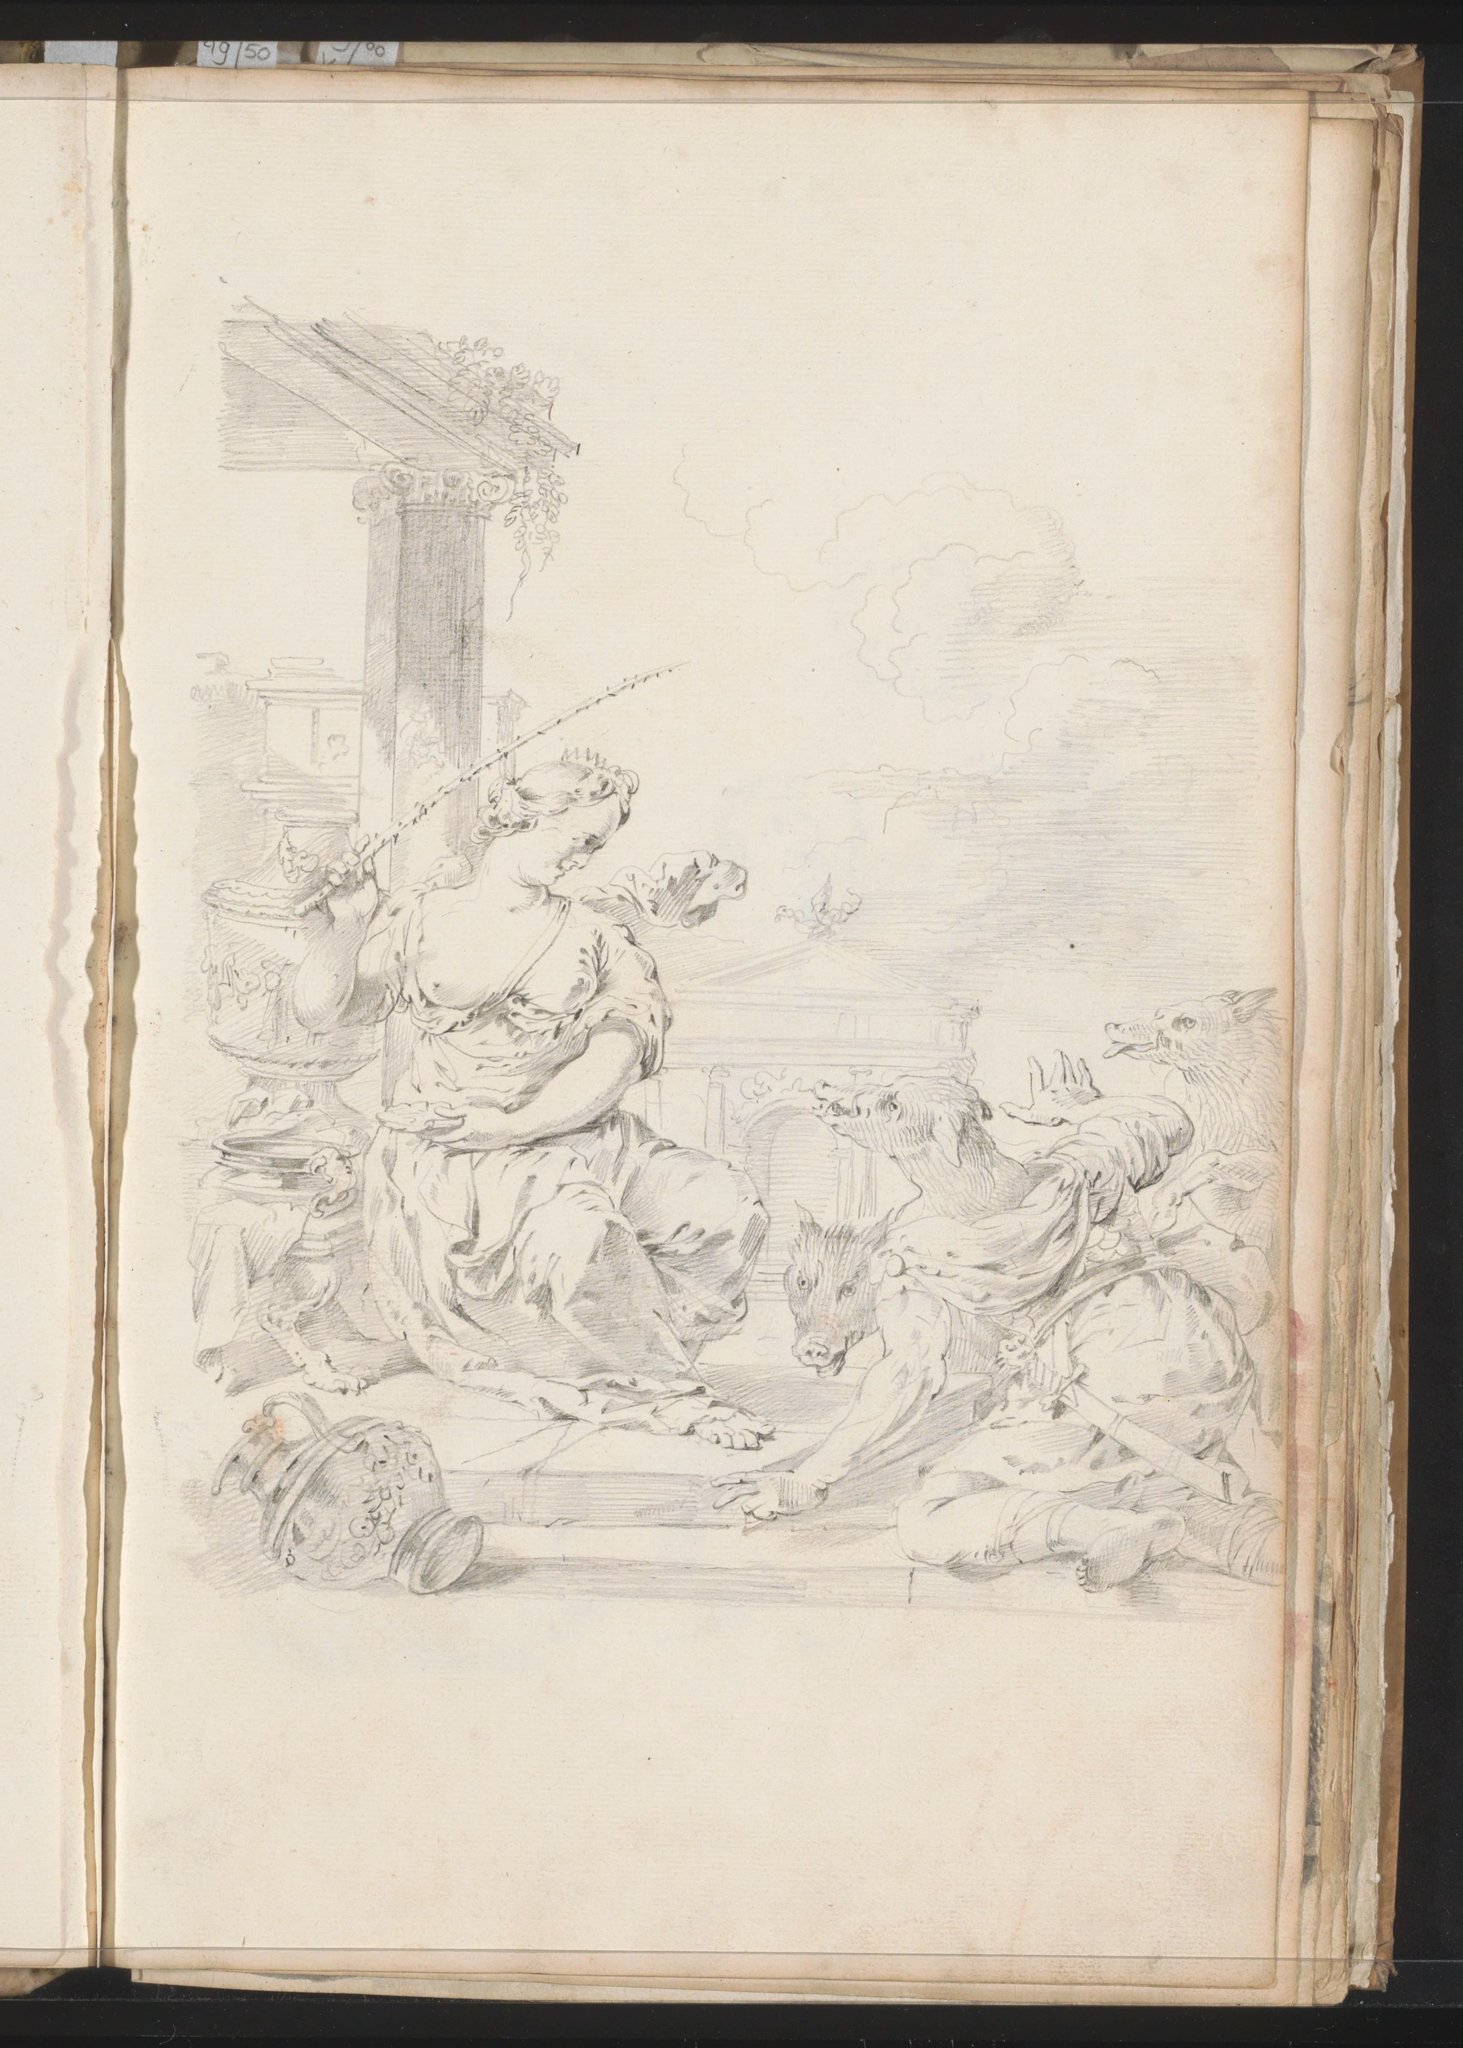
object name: sketchbook leaf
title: Circe verandert de mannen van Odysseus in zwijnen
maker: jacob toorenvliet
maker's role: draughtsman, painter, print maker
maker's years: 1640-1719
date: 1701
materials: paper, pencil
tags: ulysses' companions changed into swine: when they drink from the cup offered by circe, the enchantress, ulysses' companions change into swine (ovid, metamorphoses xiv 276)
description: Circe, gezeten met een staf en beker in de hand, kijkt neer op de soldaten met zwijnenkoppen. Op de achtergrond een gebouw met een klassieke façade. Blad 45 recto uit een schetsboek met 63 bladen.